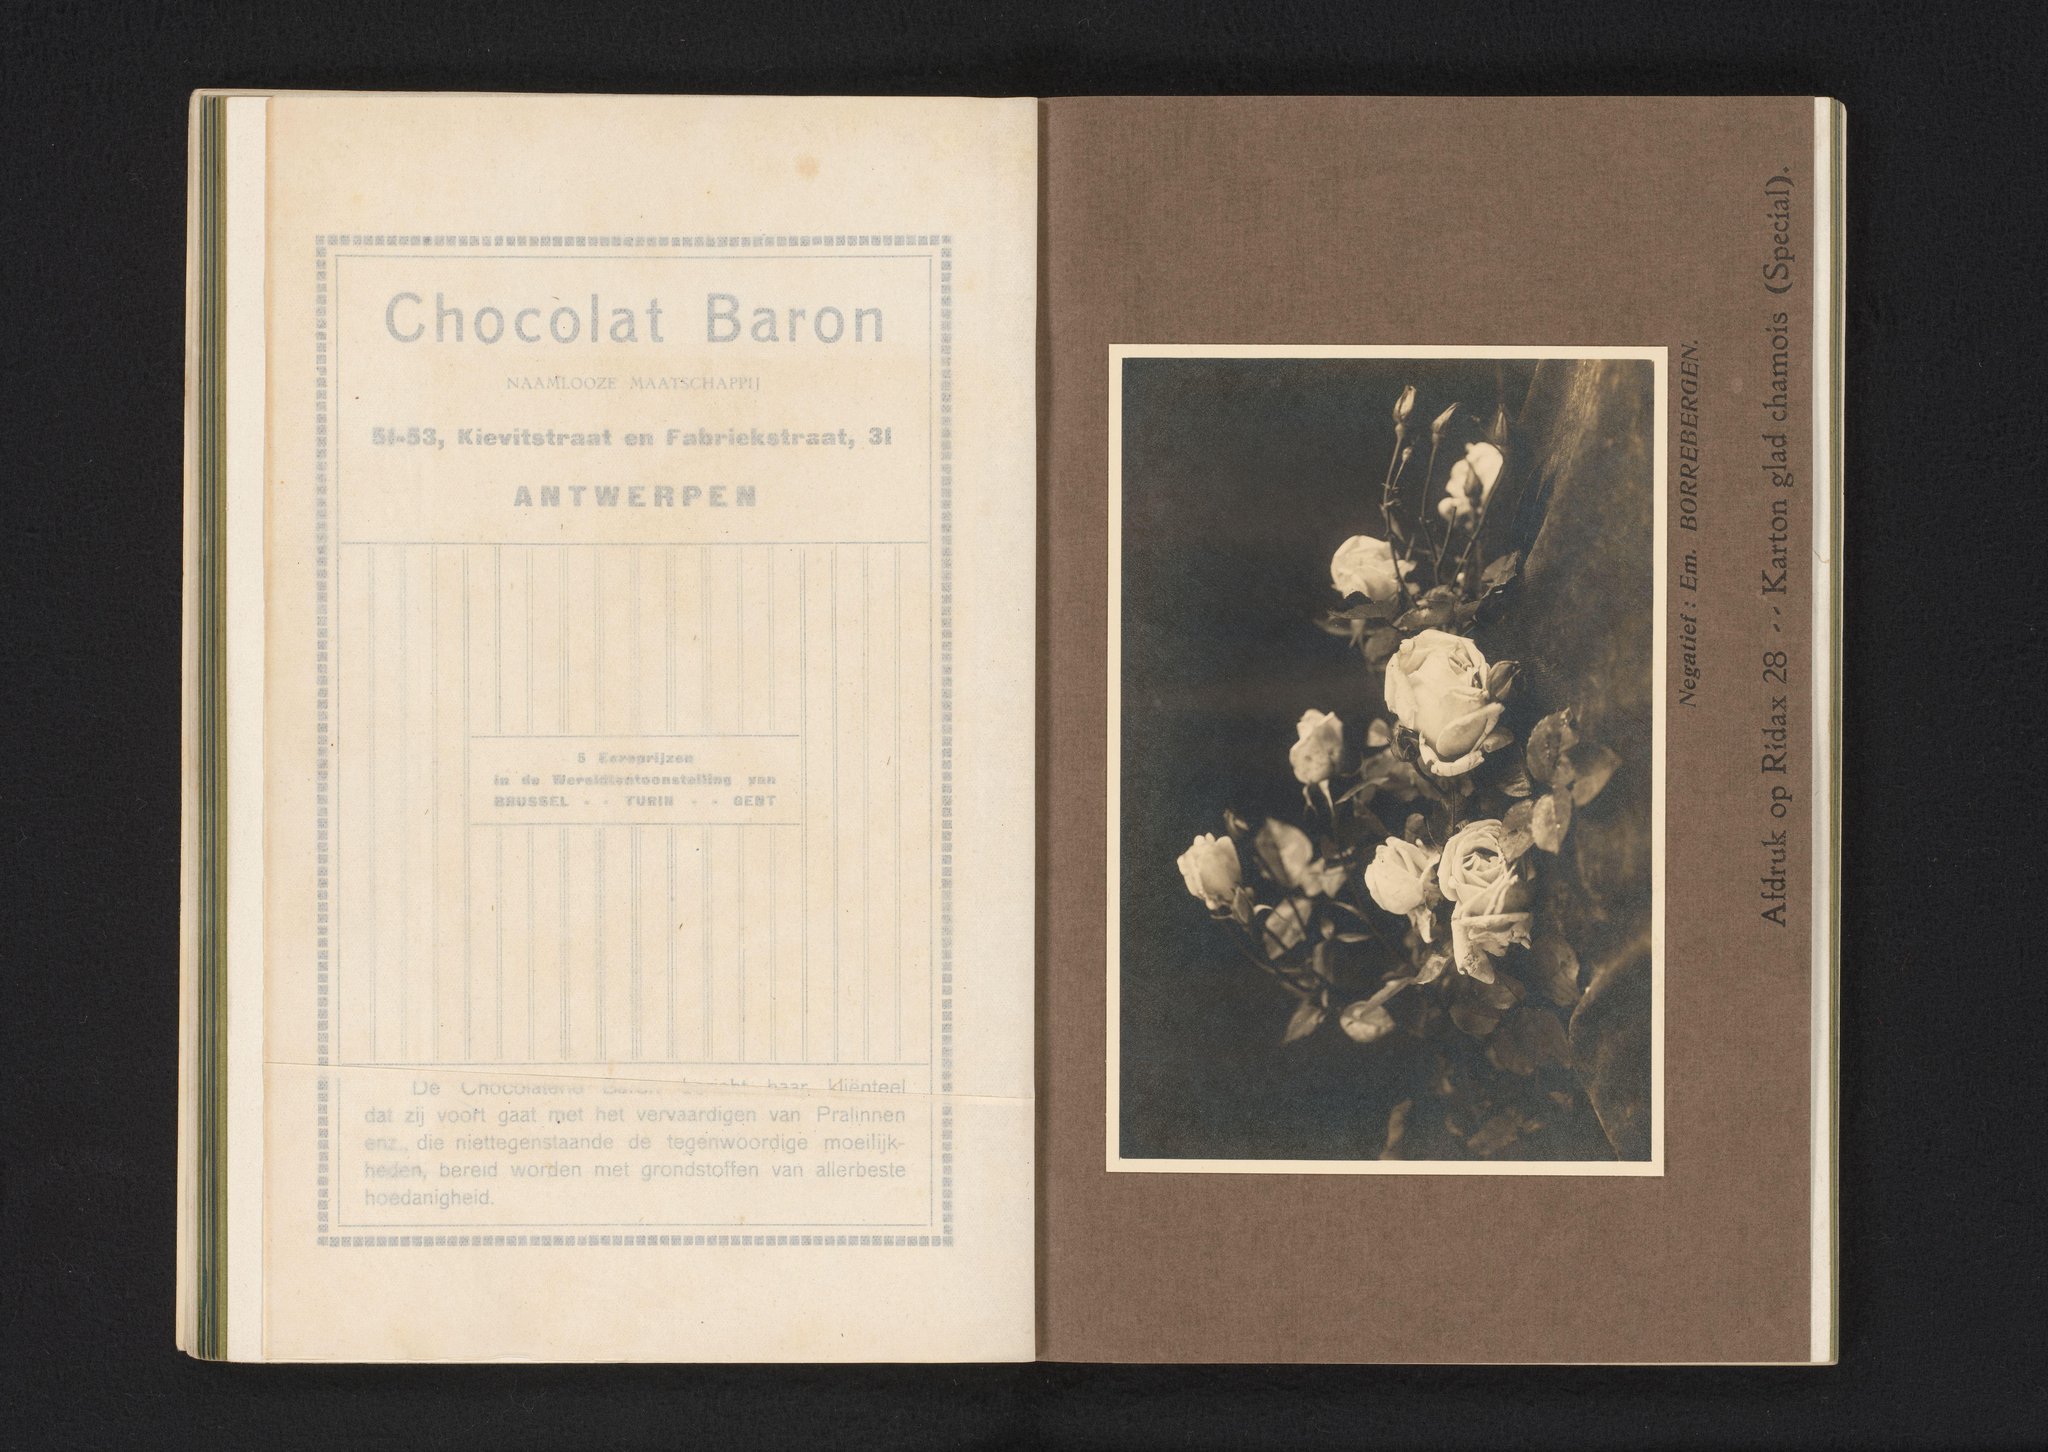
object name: page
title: Rozen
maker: jozelf emiel borrebergen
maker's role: fotograaf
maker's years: 1884-1966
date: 1911-1916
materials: photographic support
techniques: gelatin silver print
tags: flowers: rose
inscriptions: inscription: ‘Afdruk op Riax 28 - - Karton glad chamois (Sepcial)’